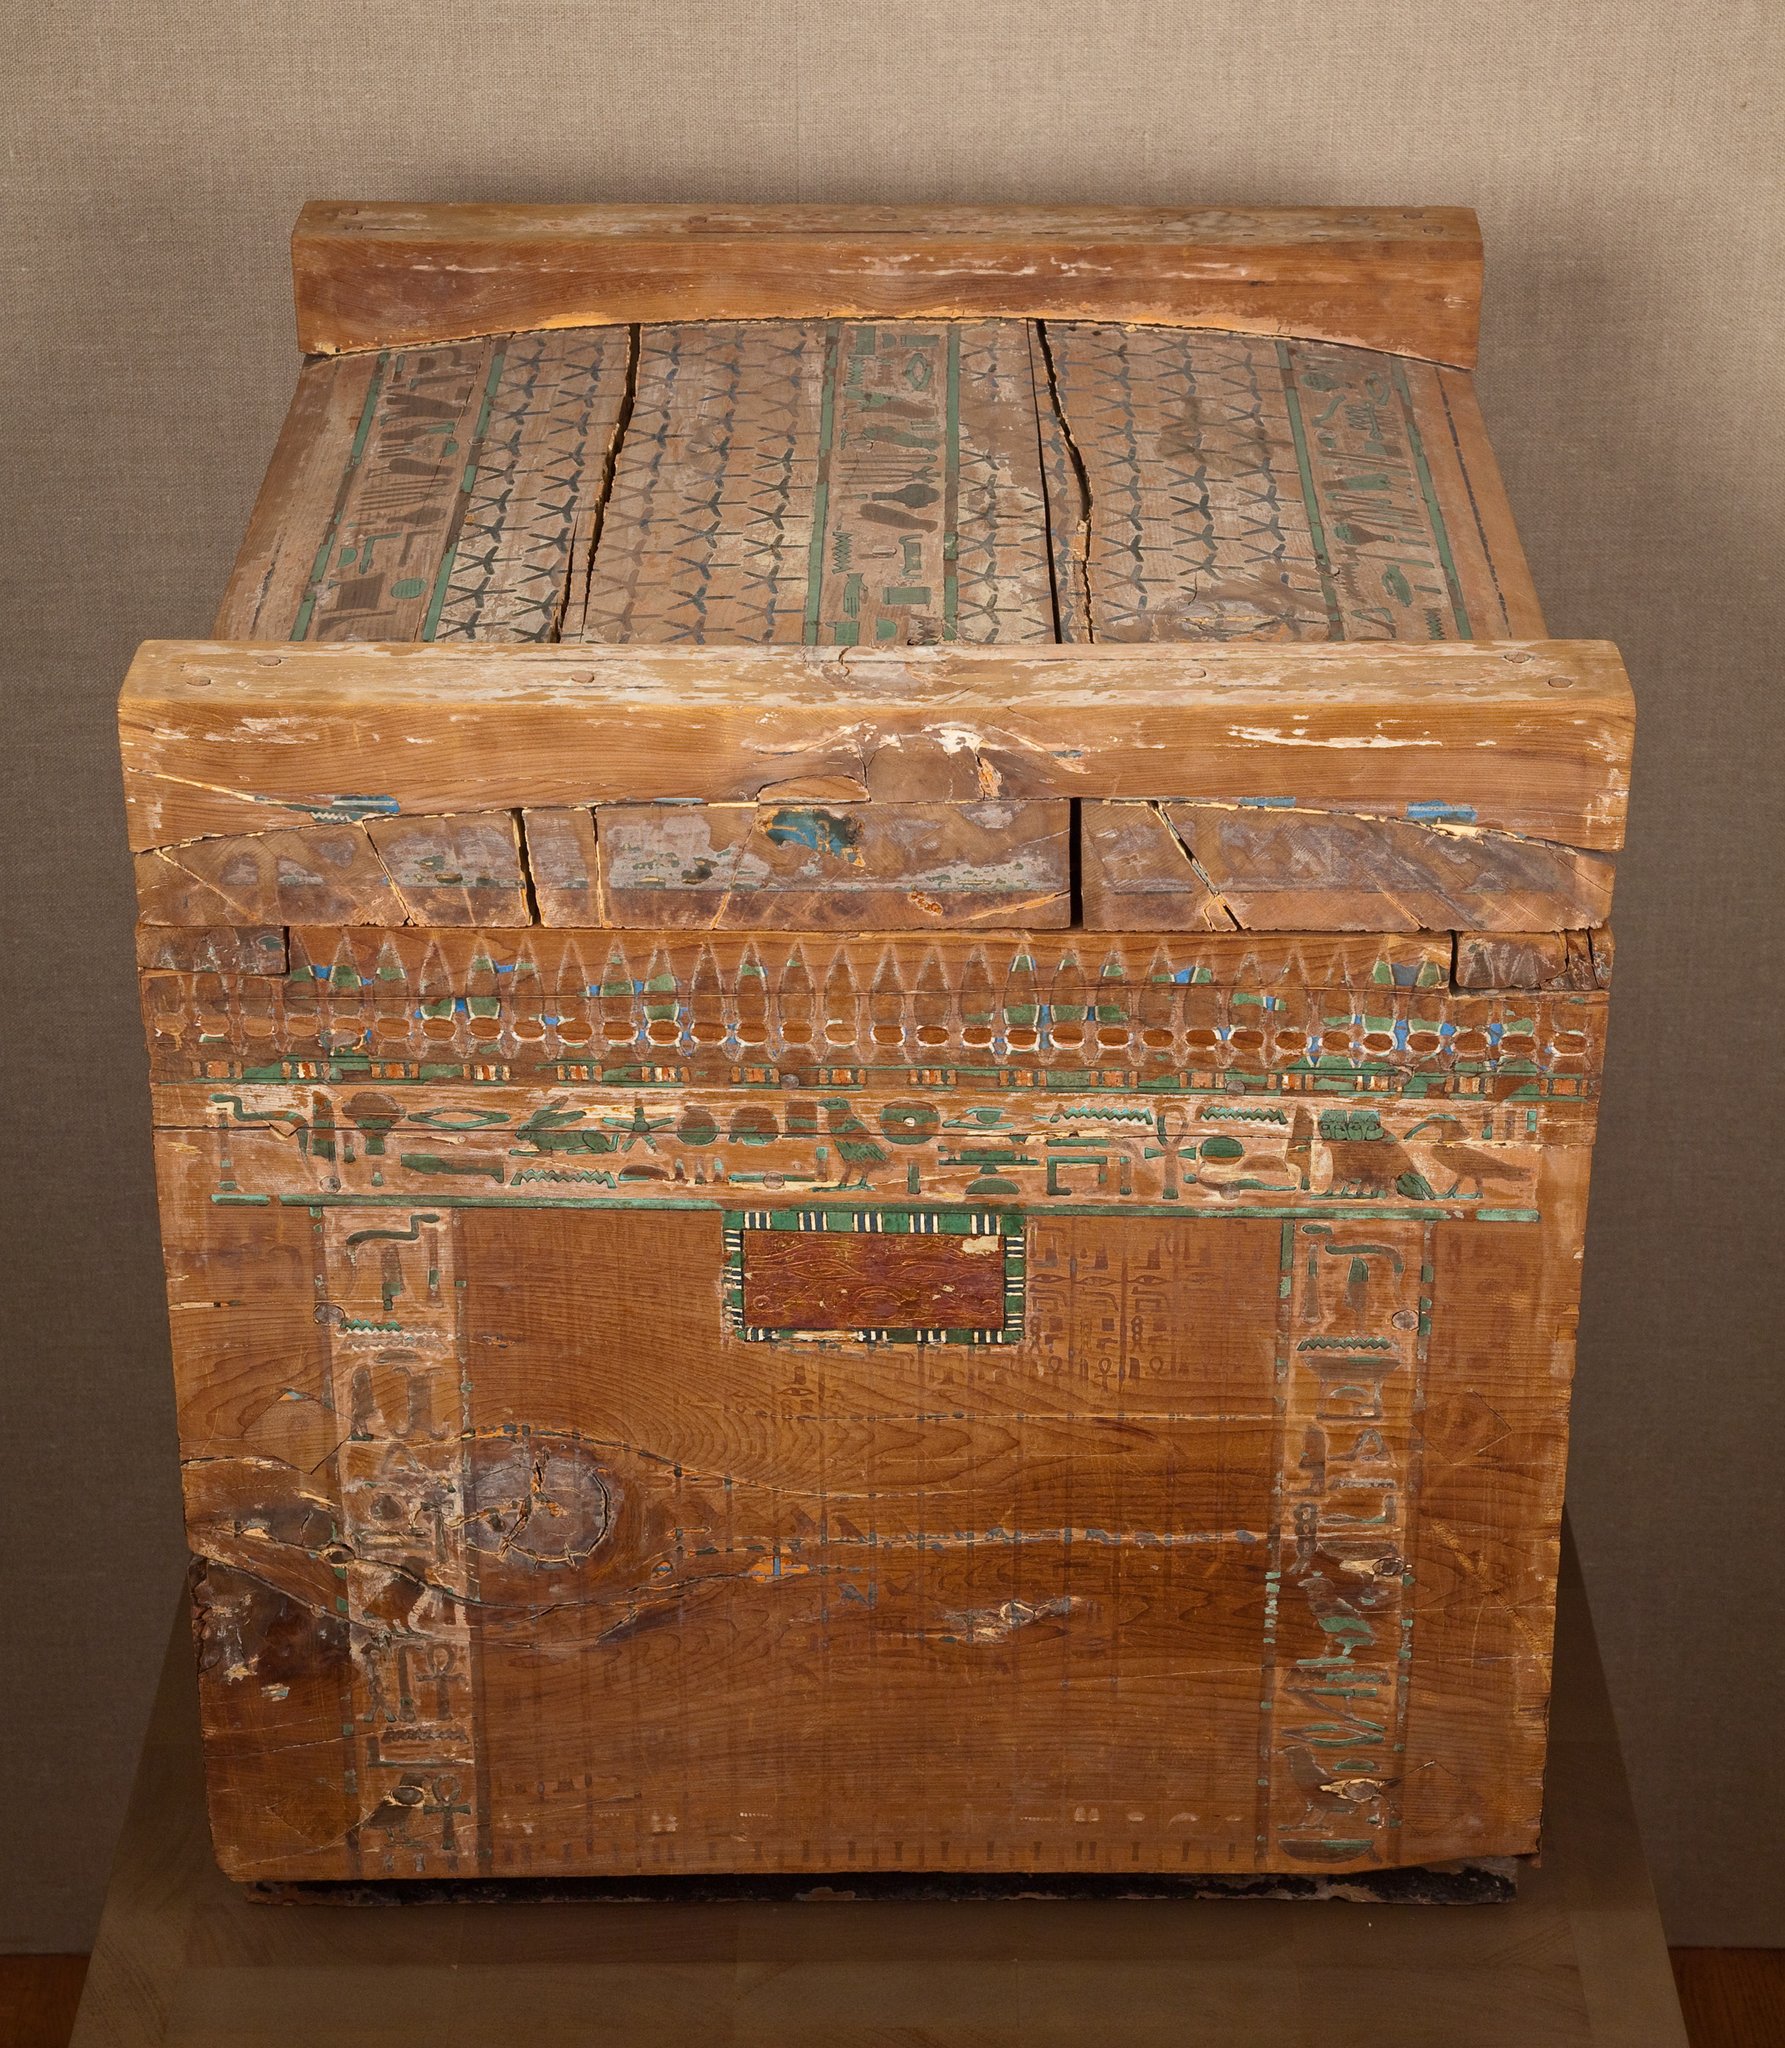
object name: canopic chest, hapiankhtifi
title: Canopic chest of Hapiankhtifi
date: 1981-1802 BCE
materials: wood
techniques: gilding, painting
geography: egypt